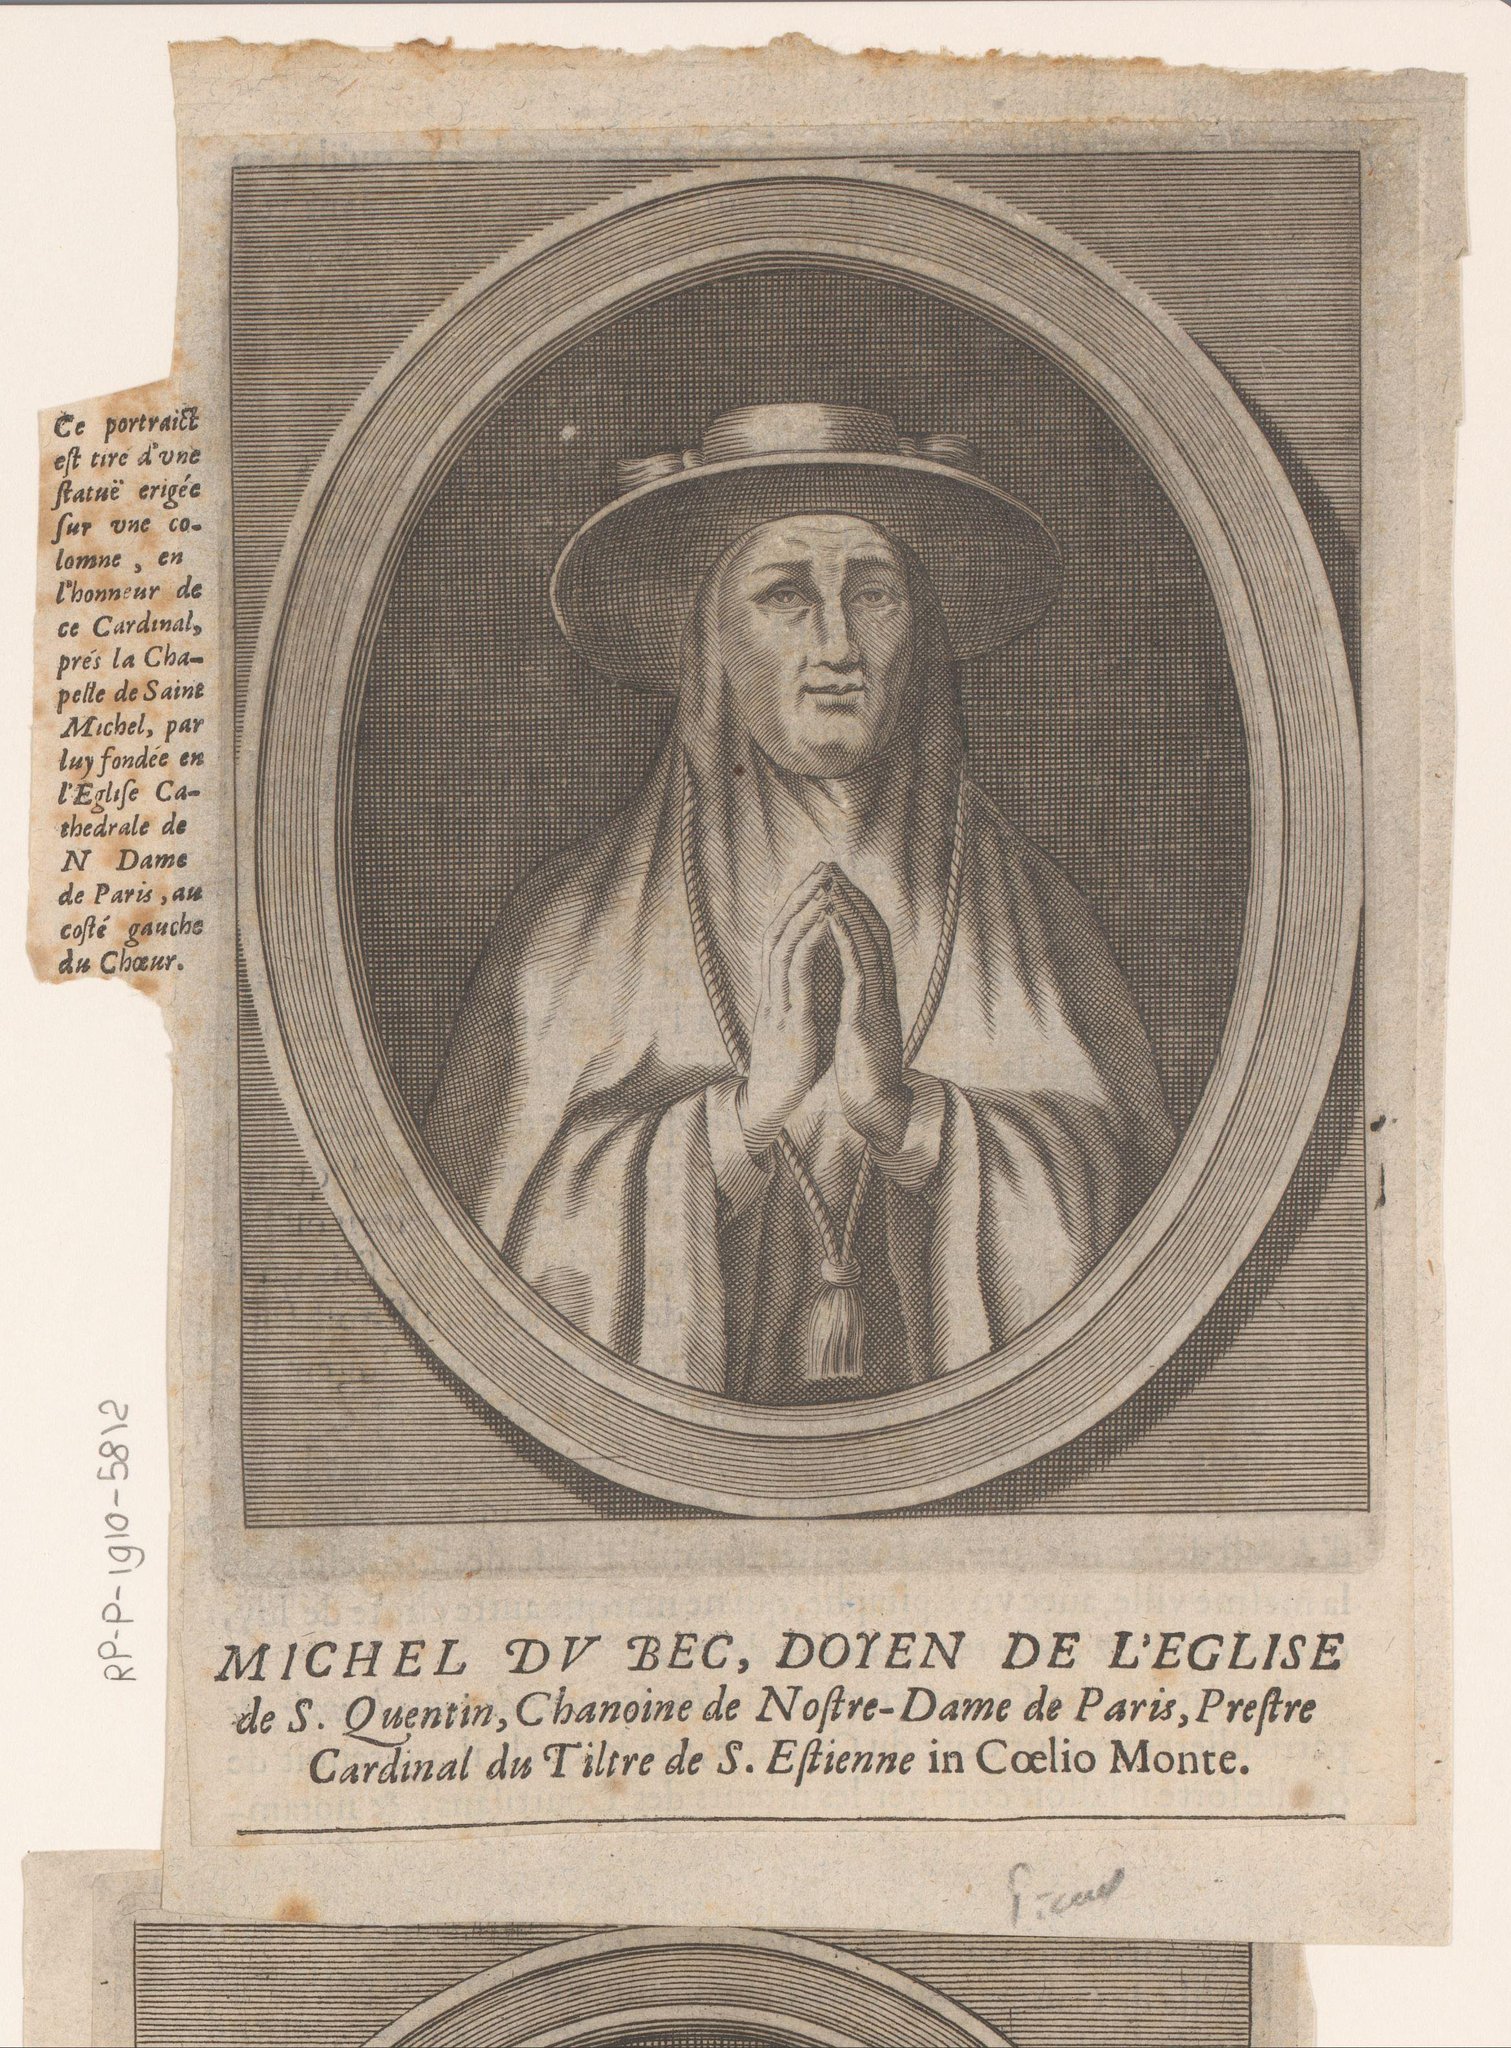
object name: book illustration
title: Michel du Bec, Doyen de l'Eglise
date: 1660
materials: paper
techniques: engraving, etching, letterpress printing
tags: cardinal, historical persons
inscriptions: collector's mark: Lugt 2228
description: Prent uit: Du Chesne, François. Histoire de tous les cardinaux françois de naissance, ou qui ont esté promeus au cardinalat. Parijs: François Du Chesne, 1660.